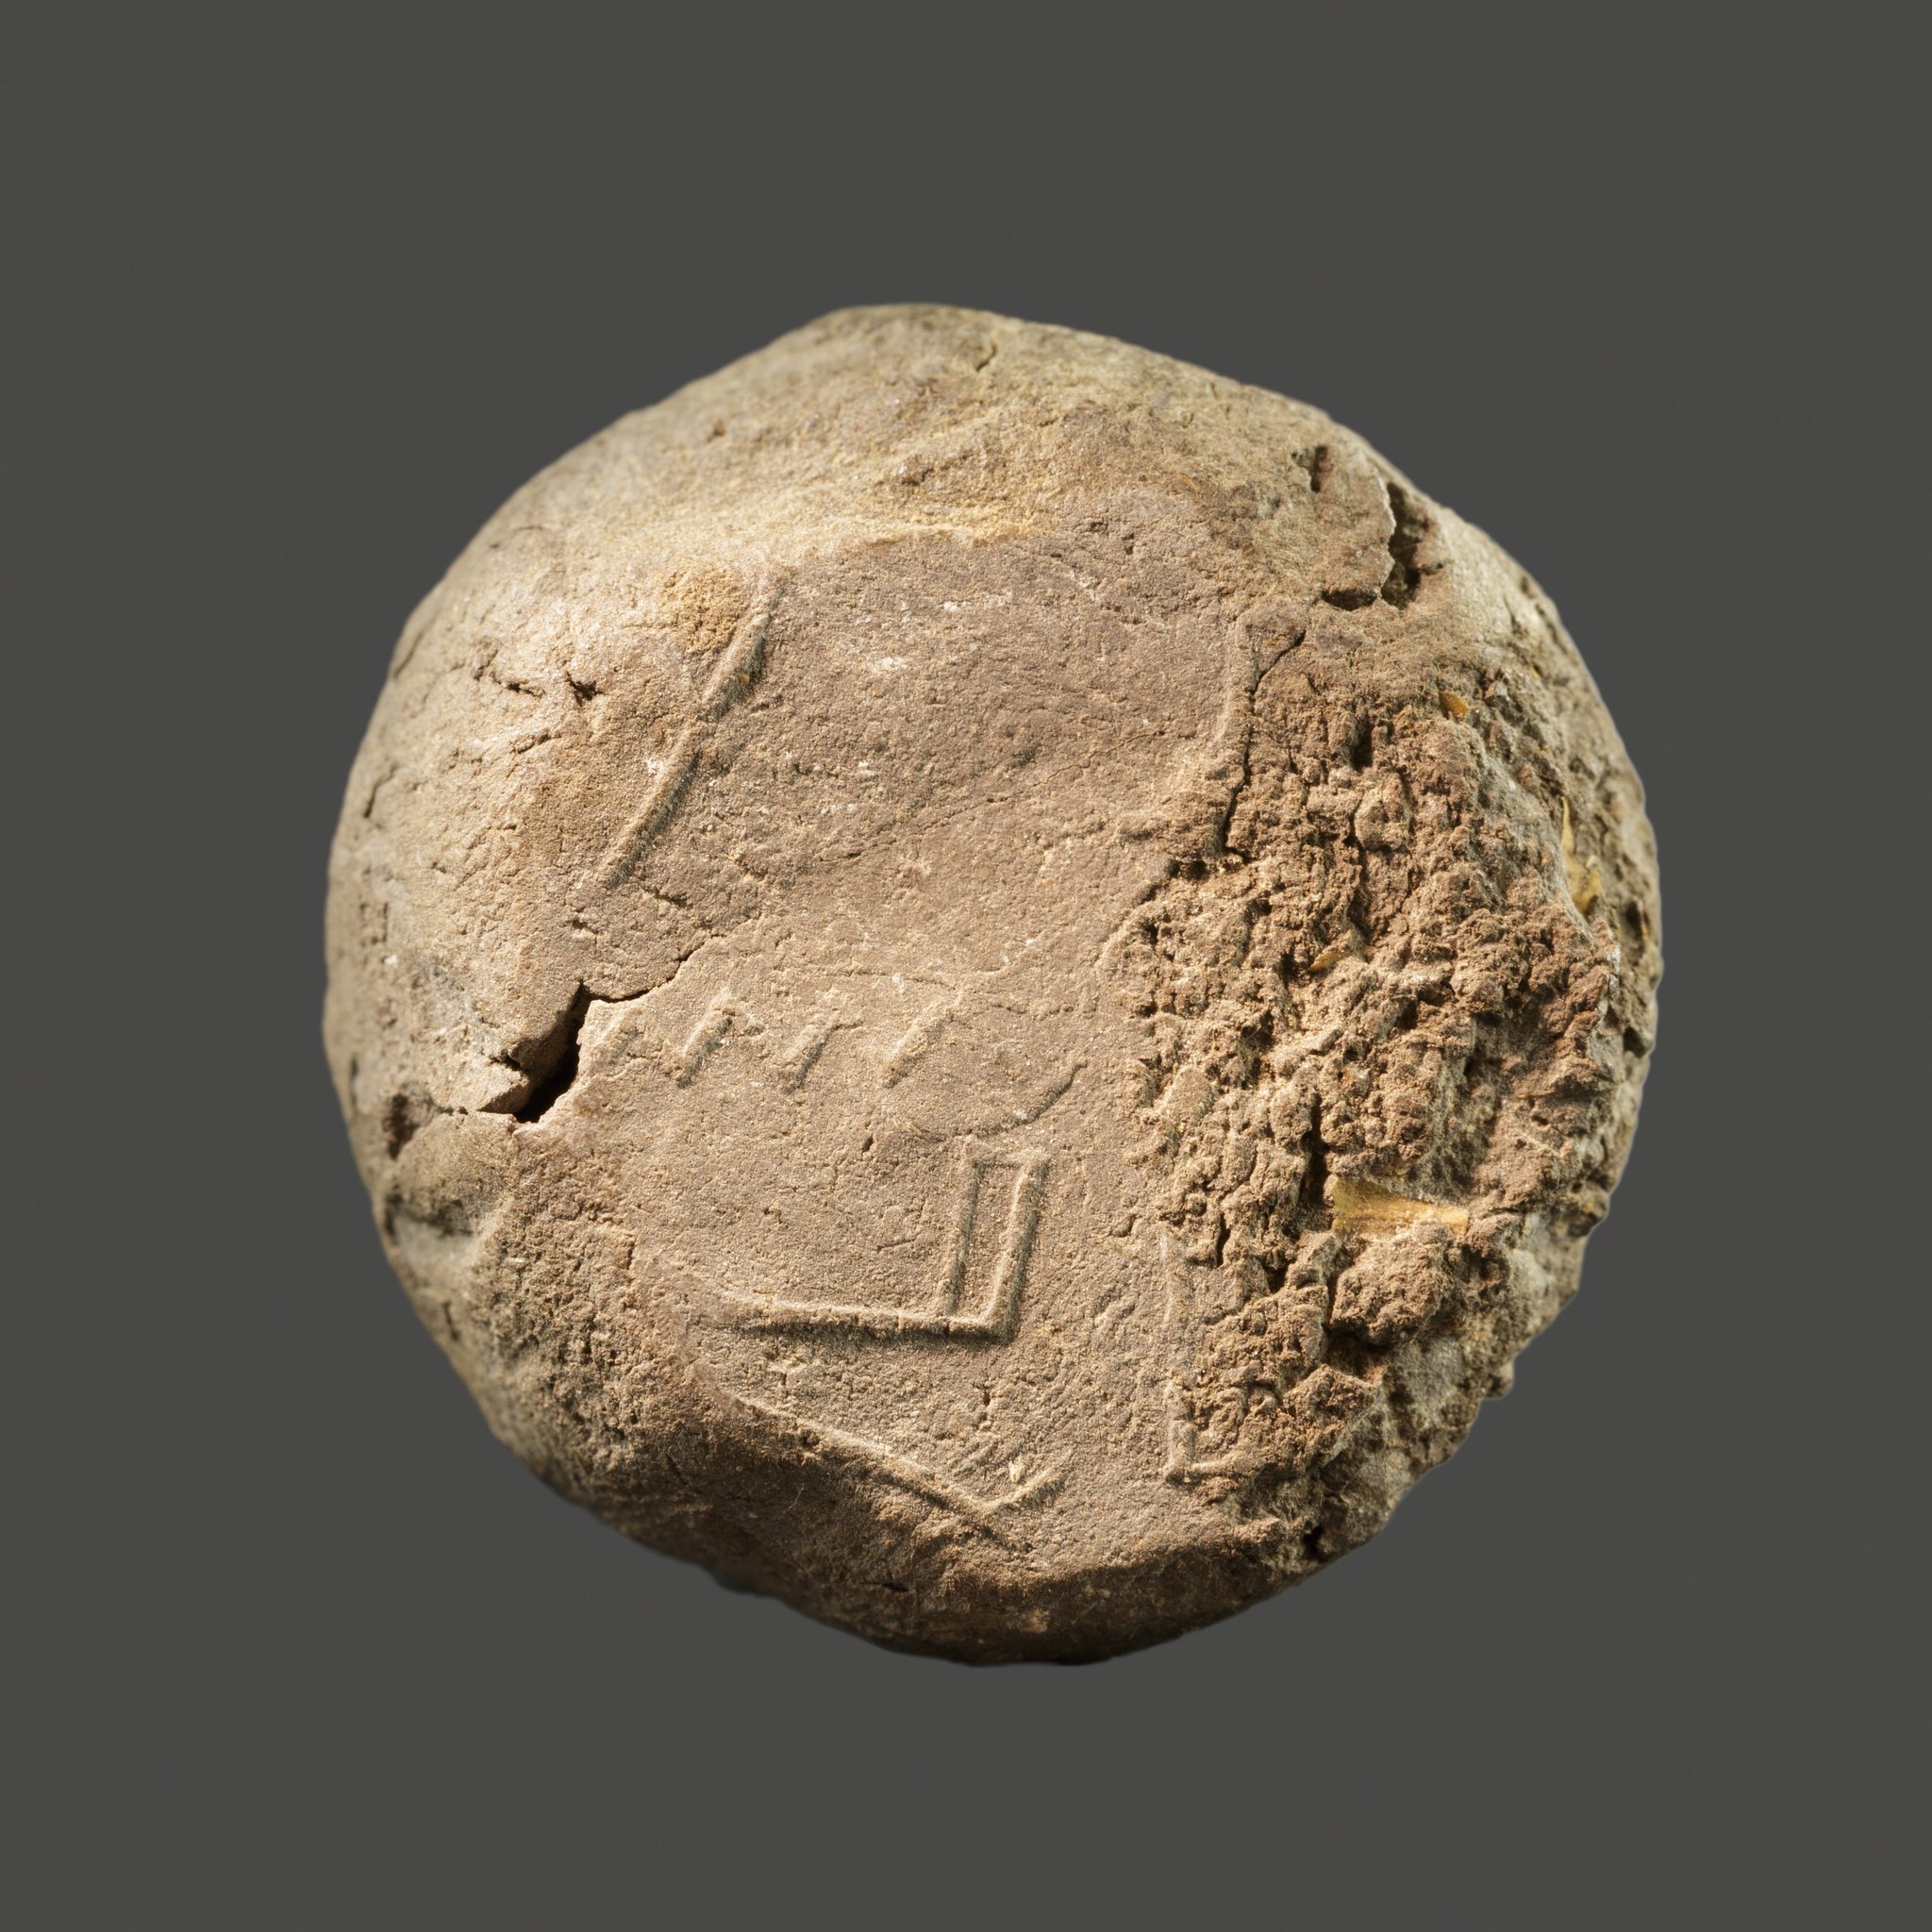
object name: reference sealing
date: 1961-1954 BCE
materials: mud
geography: egypt